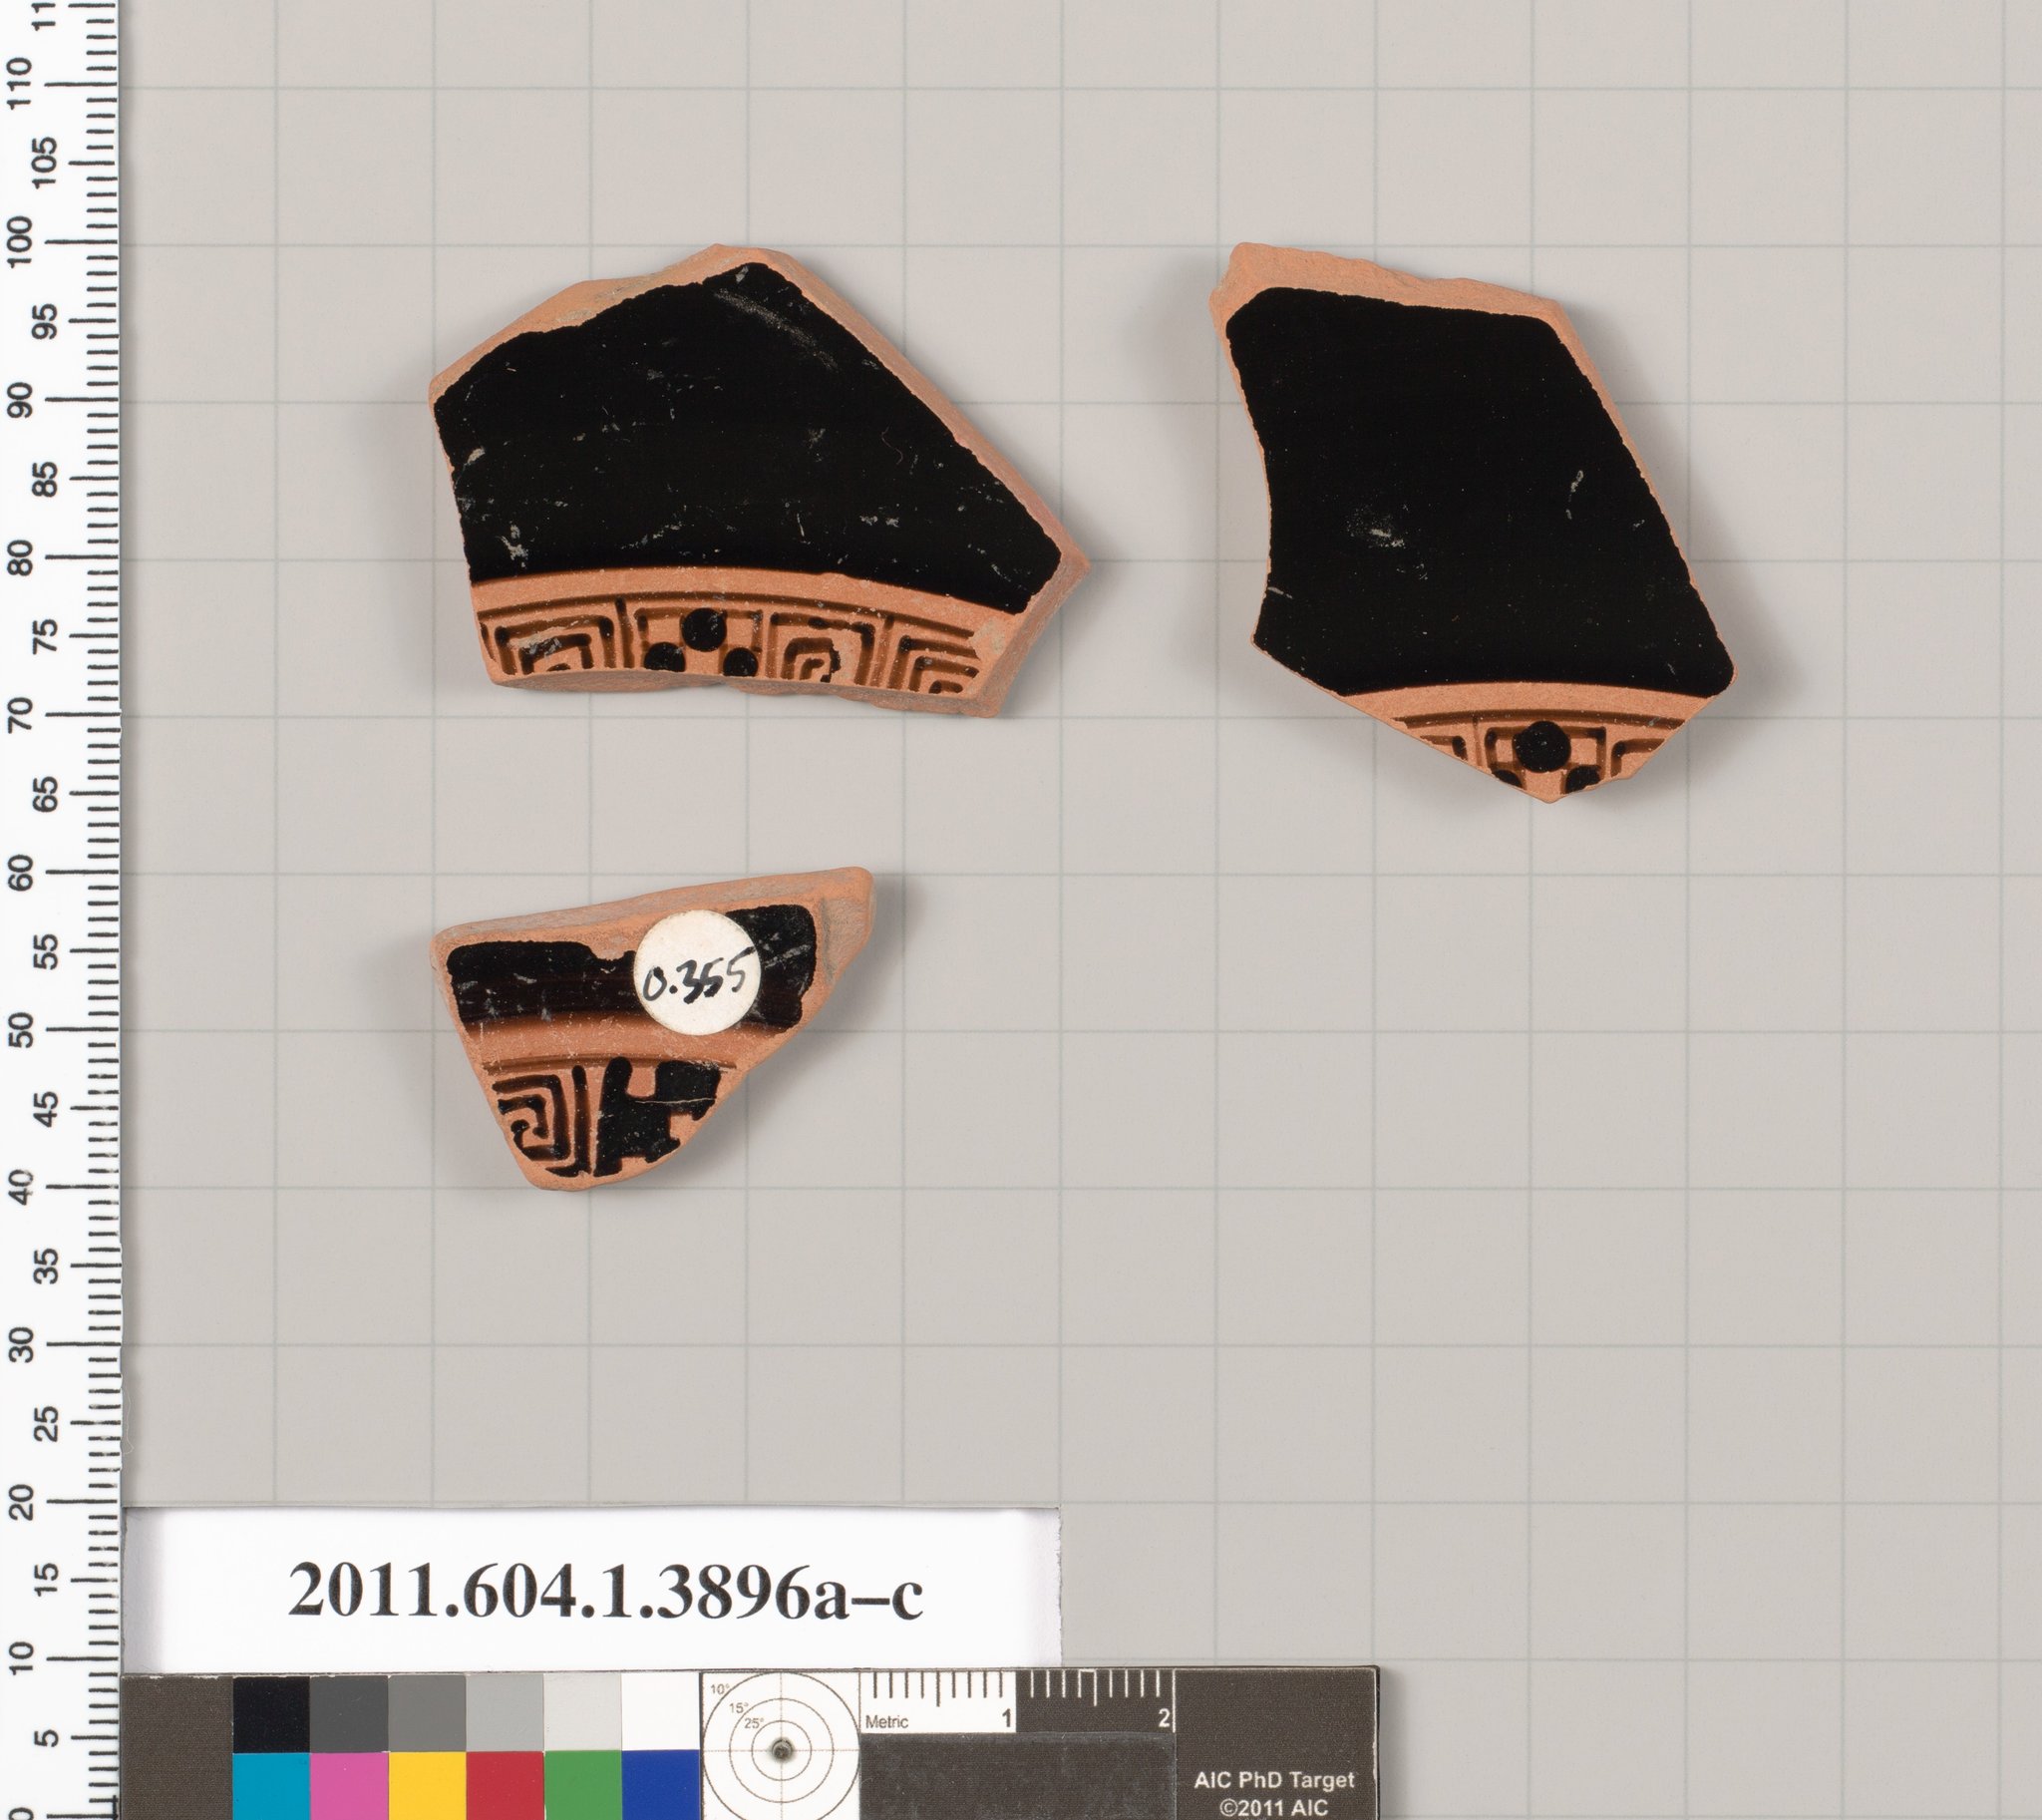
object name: kylix fragment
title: Terracotta fragments of kylikes (drinking cups)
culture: greek, attic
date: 475-451 BCE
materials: terracotta